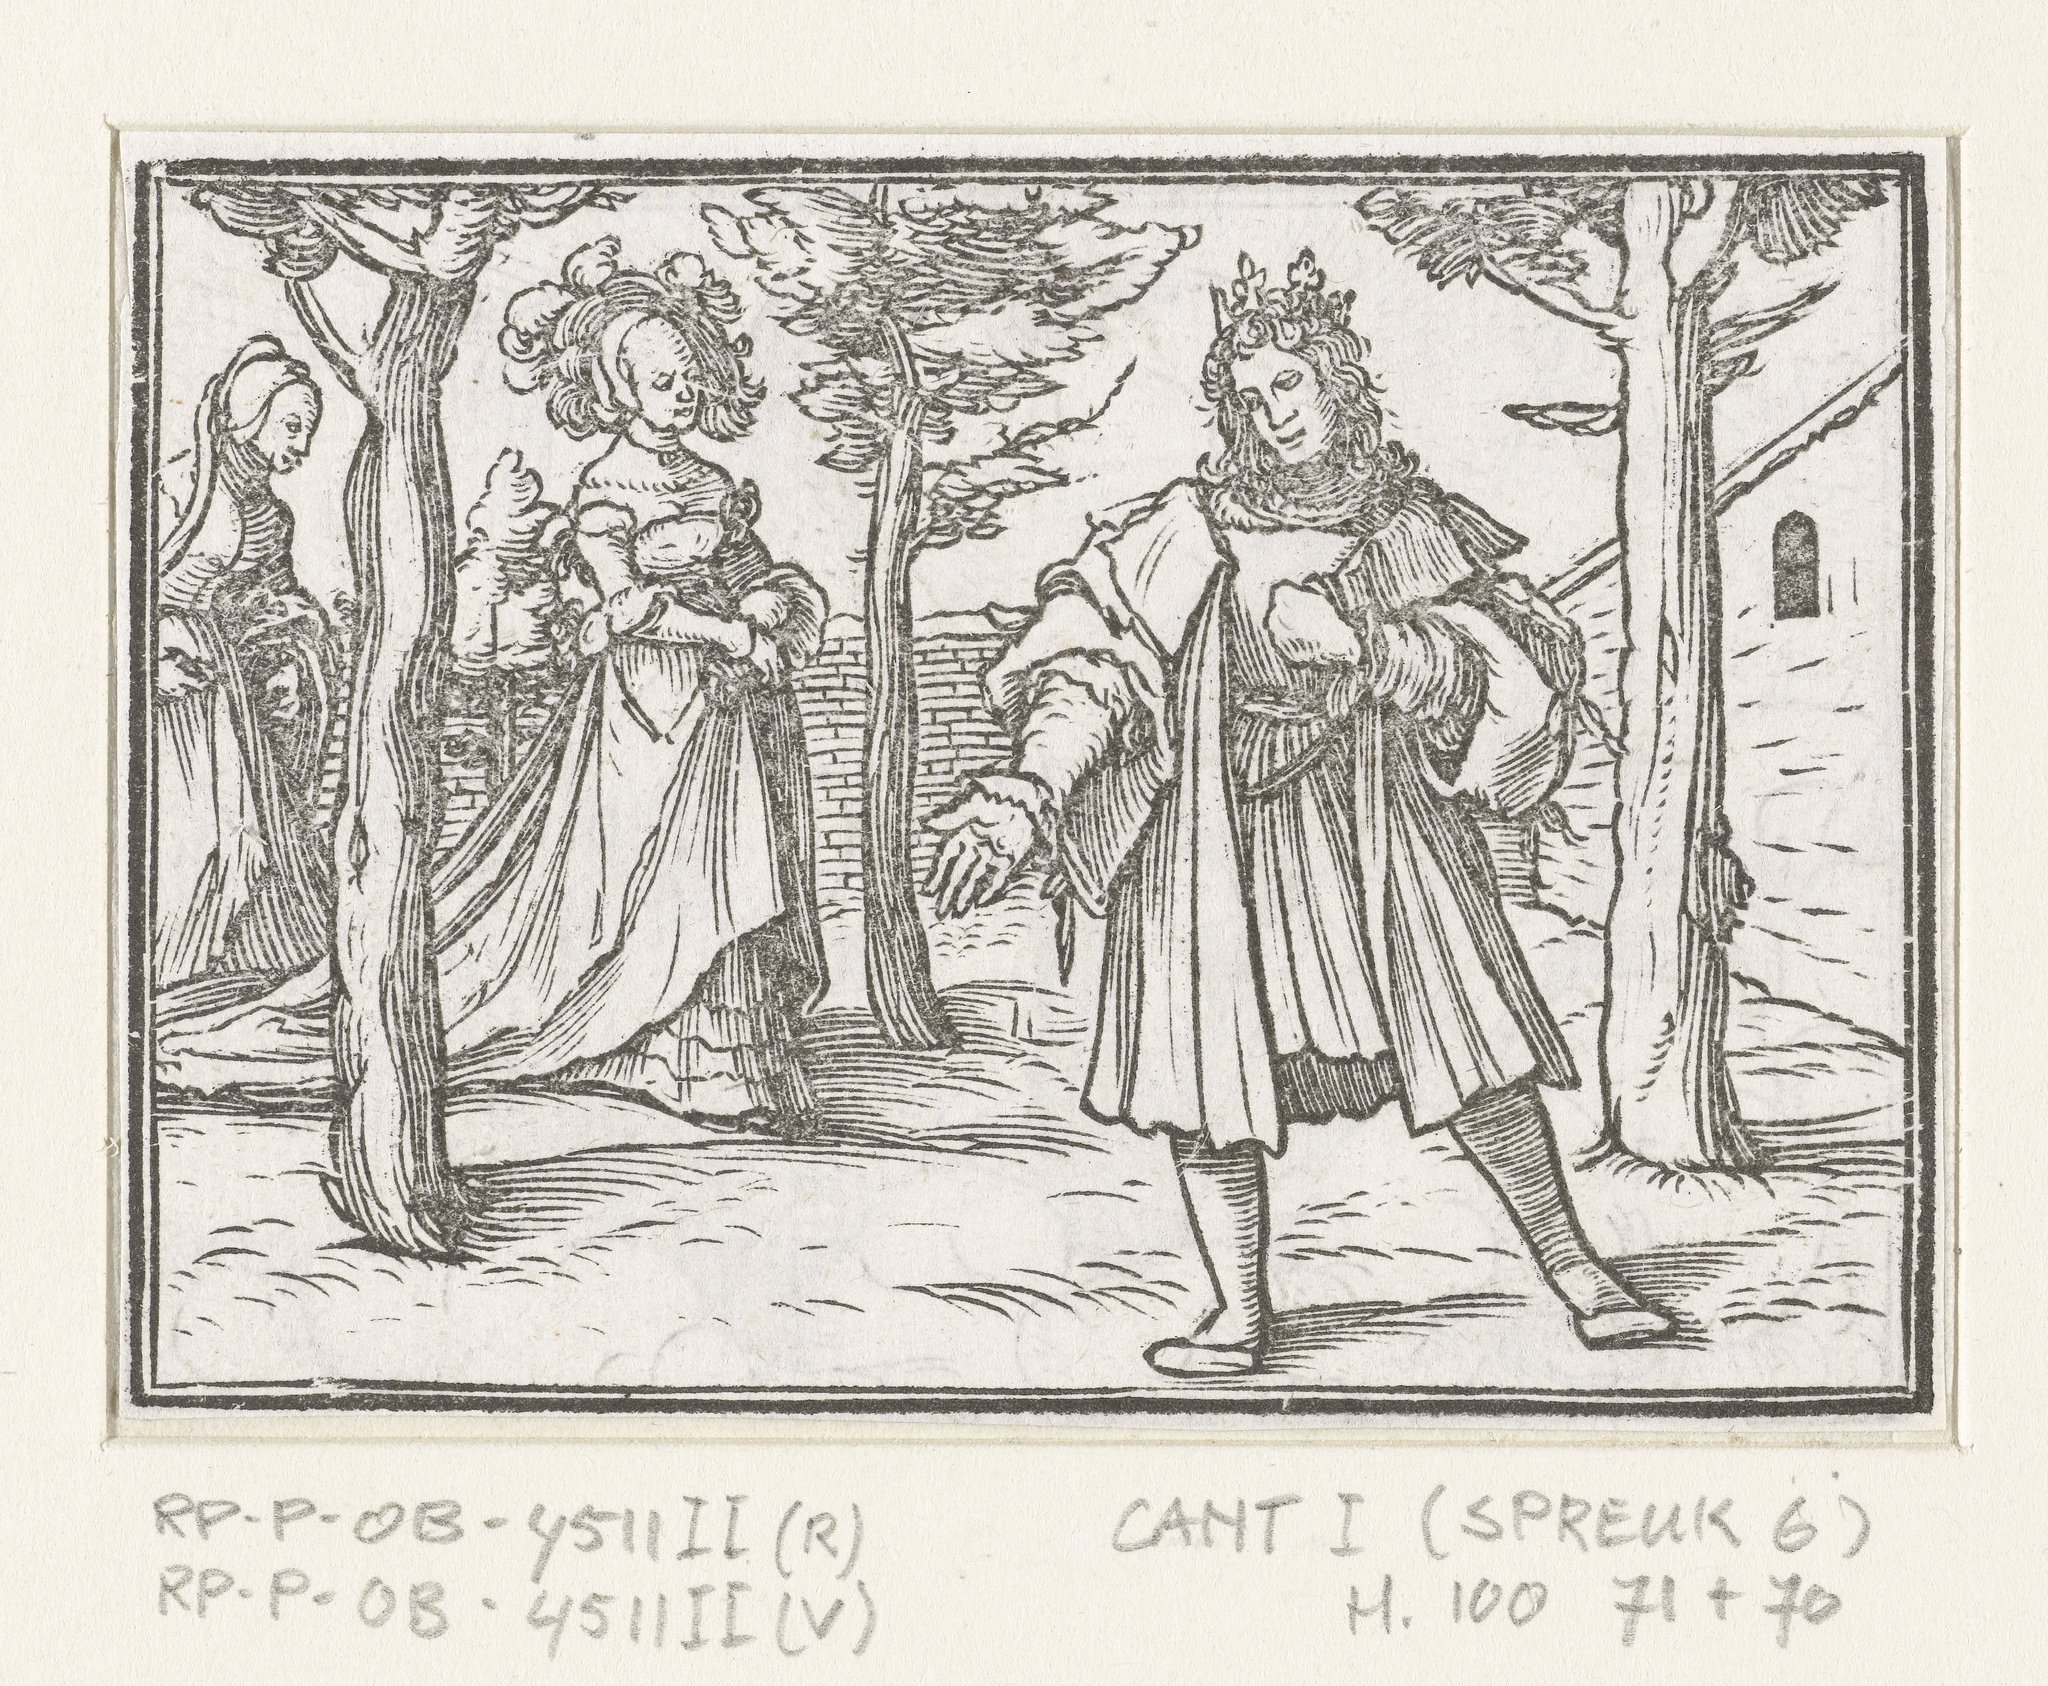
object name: book illustration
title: Man wordt verleid door lichtzinnige vrouw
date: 1538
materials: paper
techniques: woodcut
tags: unsuccessful love affair; seduction, the book of proverbs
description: In een tuin heeft een man een ontmoeting met een lichtzinnige vrouw. De afbeelding is een illustratie bij Spreuken 6 waarin wordt gewaarschuwd voor overspel. In de marge boven de afbeelding staat de tekst Cant[...] I.